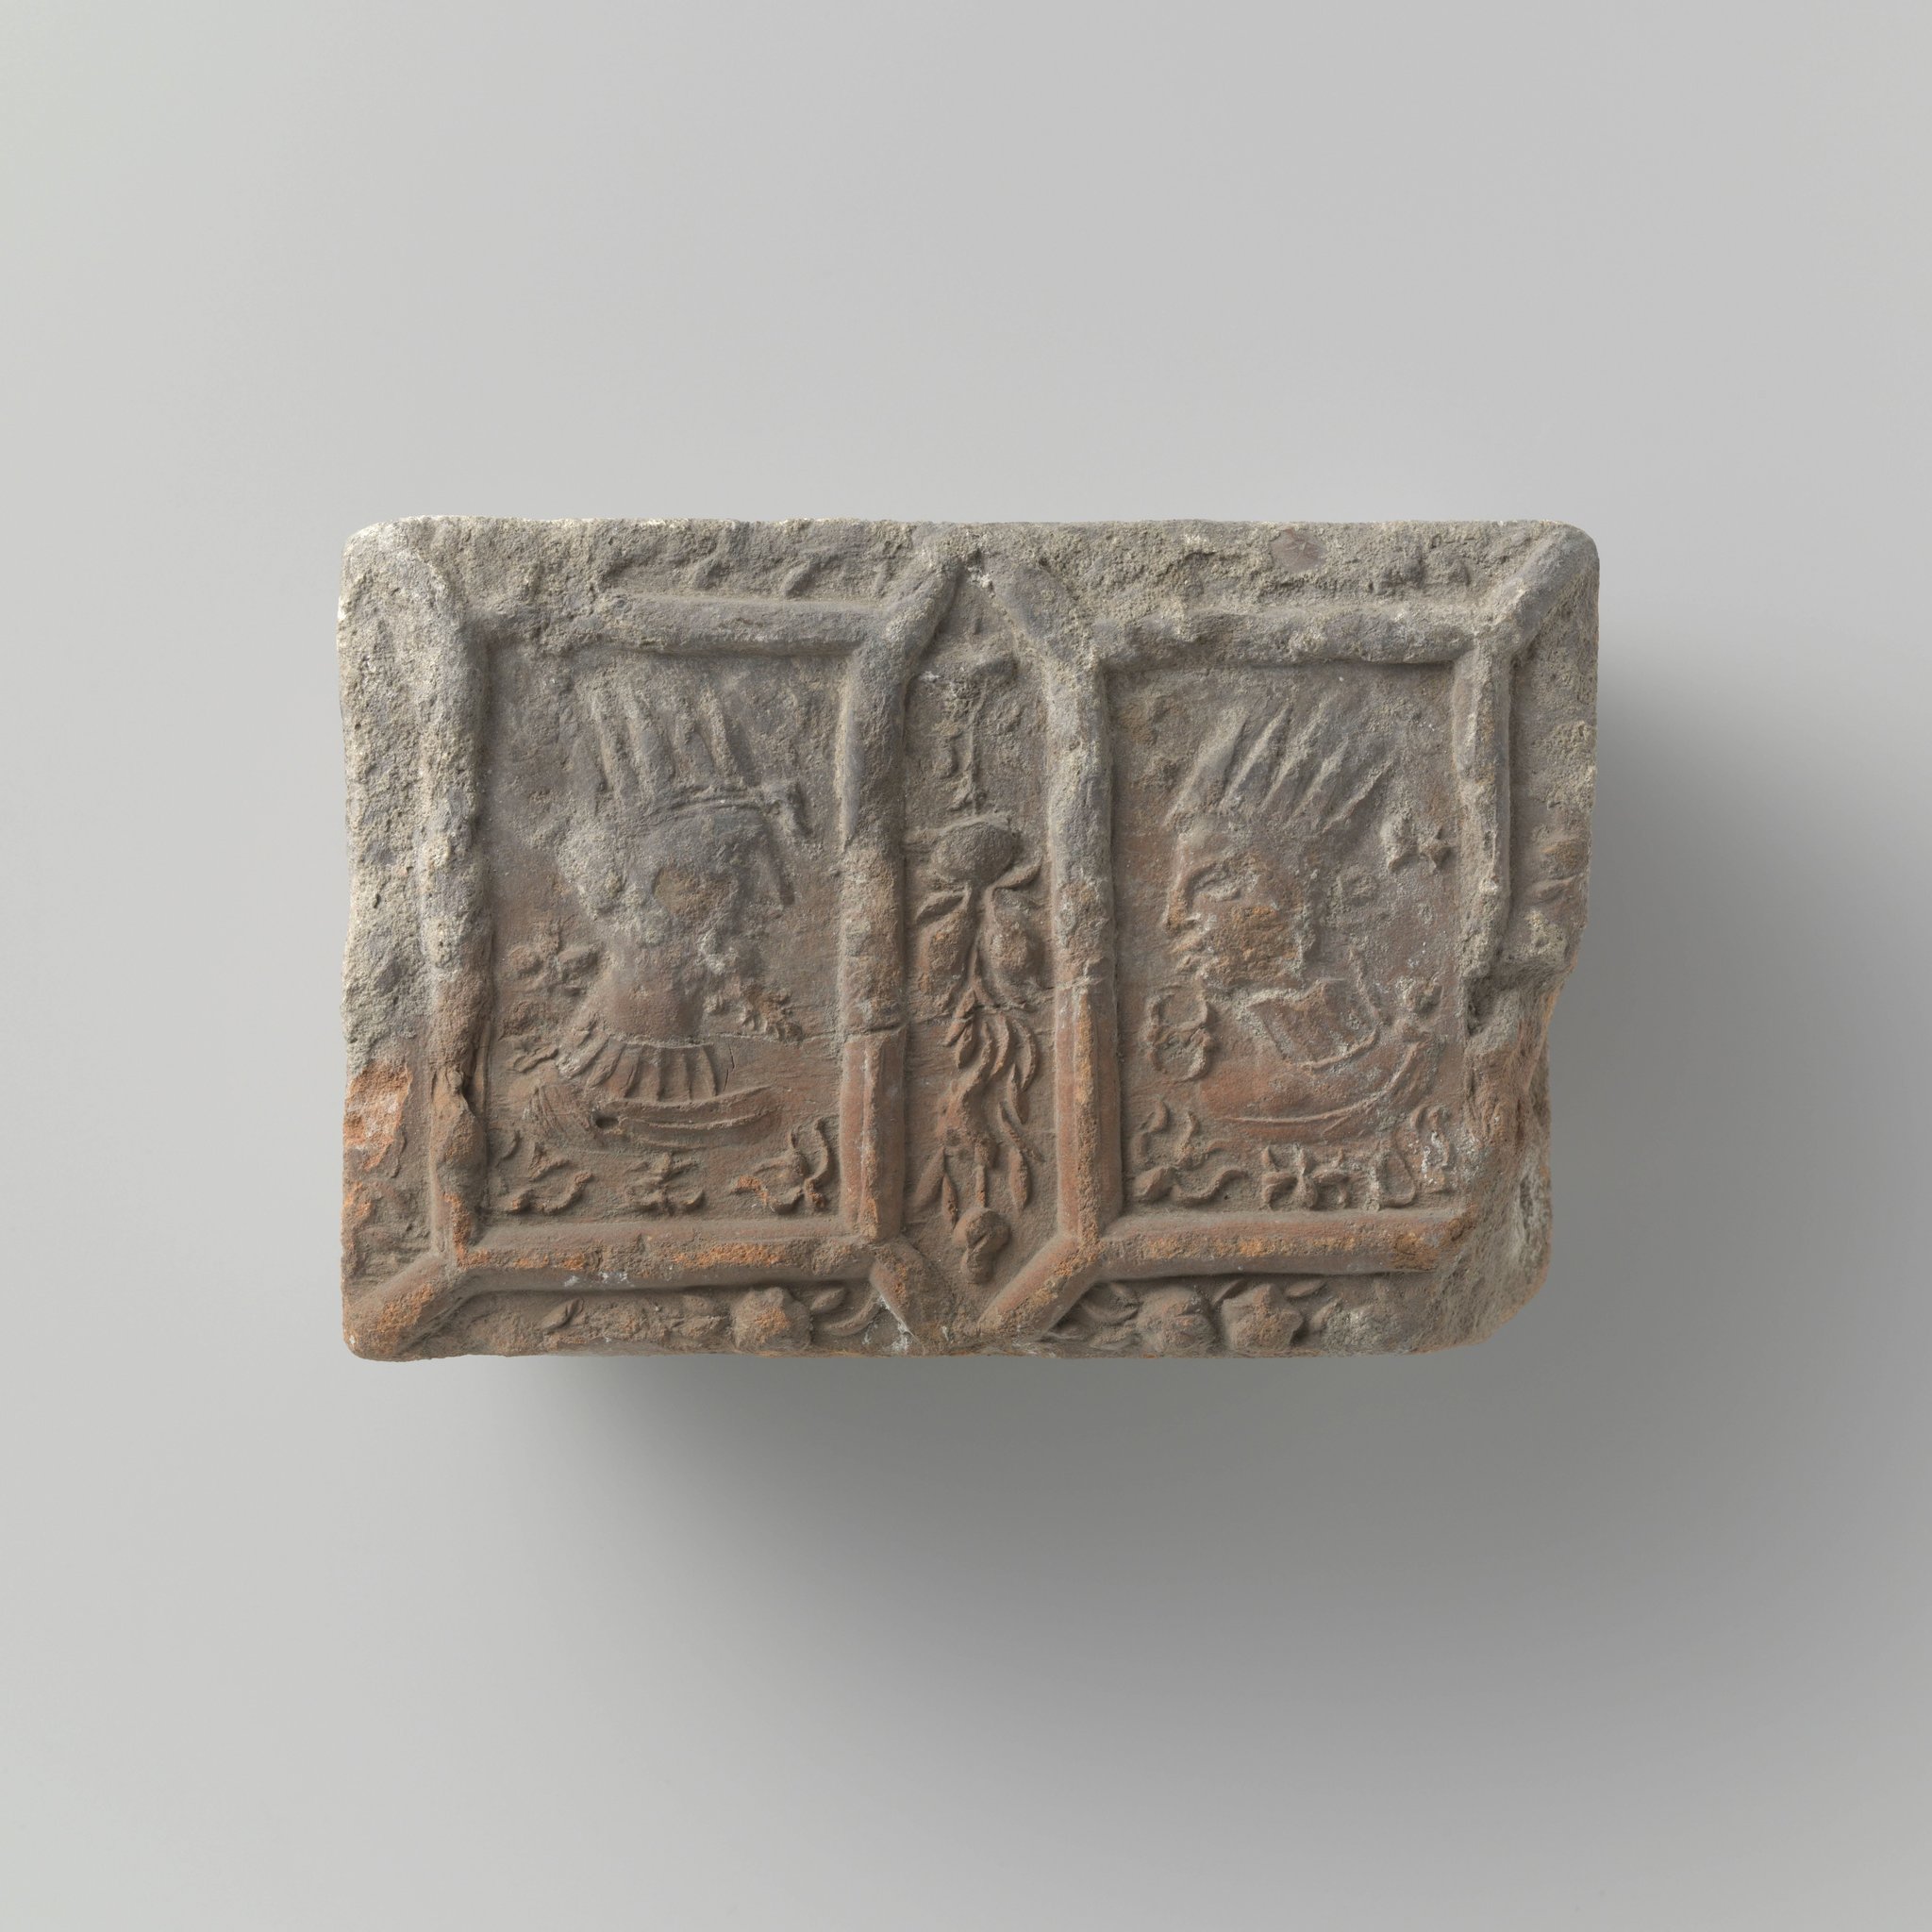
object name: hearthstone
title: Fragment van een haardsteen met een afbeelding van een gekroonde mannen- en vrouwenkop, omgeven door festoenen.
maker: Anonymous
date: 1575-1599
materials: earthenware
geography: antwerp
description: Fragment van een haardsteen met een afbeelding van twee vorstelijke busten; een man en een vrouw.